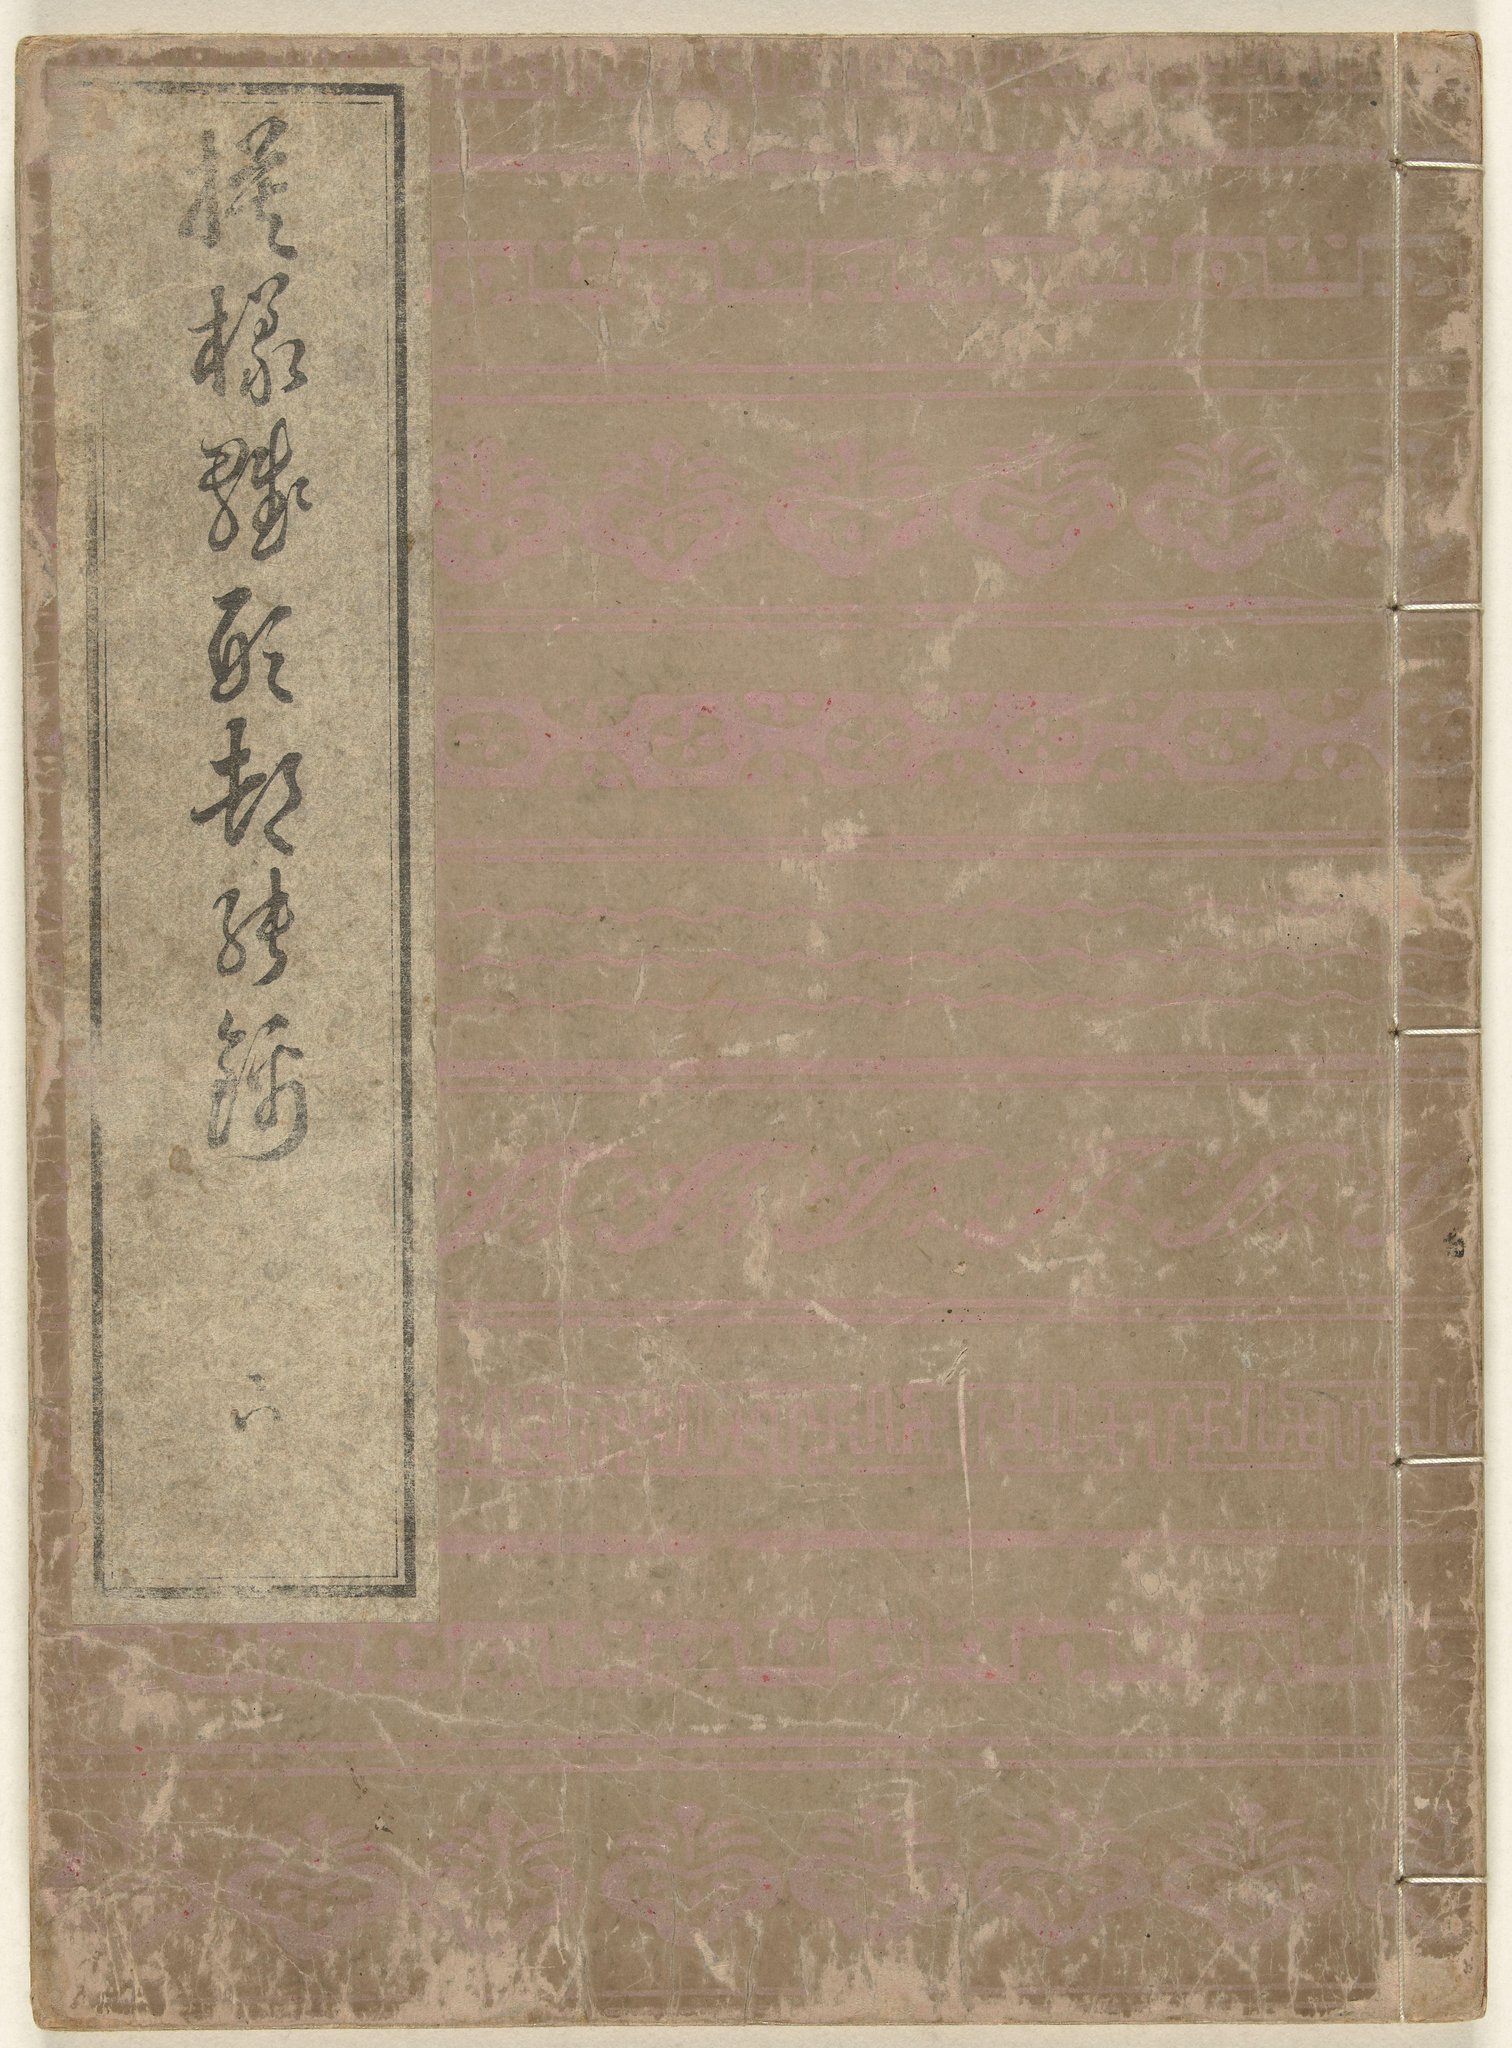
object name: book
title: Patroonmodellen voor brokaten uit de hoofdstad - drie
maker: Anonymous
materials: paper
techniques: woodcut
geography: osaka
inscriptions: date